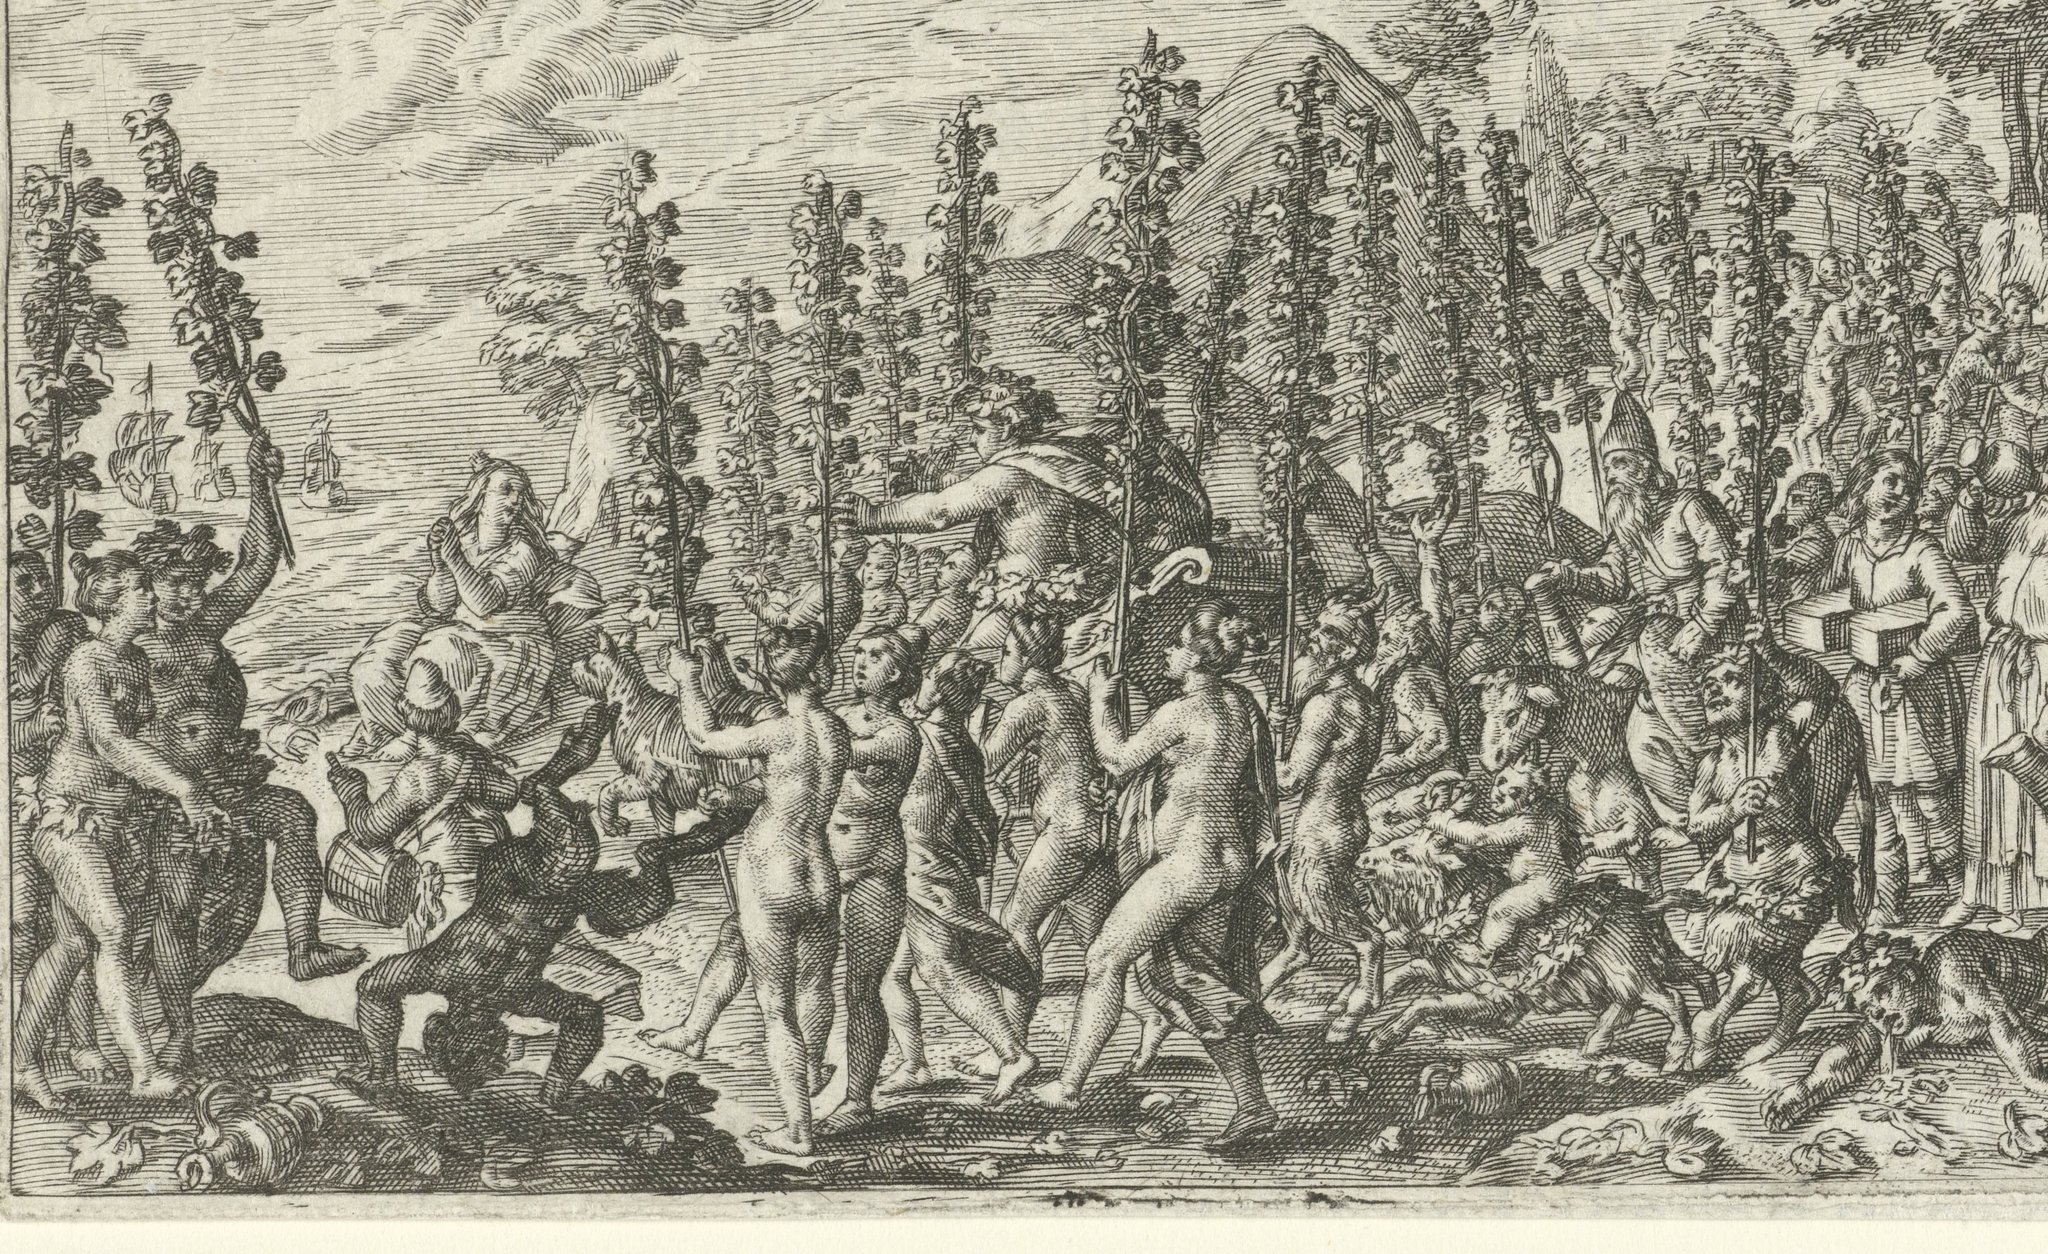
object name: print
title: Bacchus vindt Ariadne op Naxos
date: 1616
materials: paper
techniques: engraving, letterpress printing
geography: amsterdam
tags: offspring, companion(s), train etc. of bacchus, bacchus finds ariadne on naxos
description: Boekillustratie voor: Heinsius, Daniel [bewerkt door Petrus Scriverius]. Nederduytsche poemata. dl. 3: Hymnus oft Lof-sanck van Bacchus, Waerin'tgebruyck ende misbruyck vande Wijn beschreven wort. Amsterdam: Willem Jansz Blaeu, 1616.